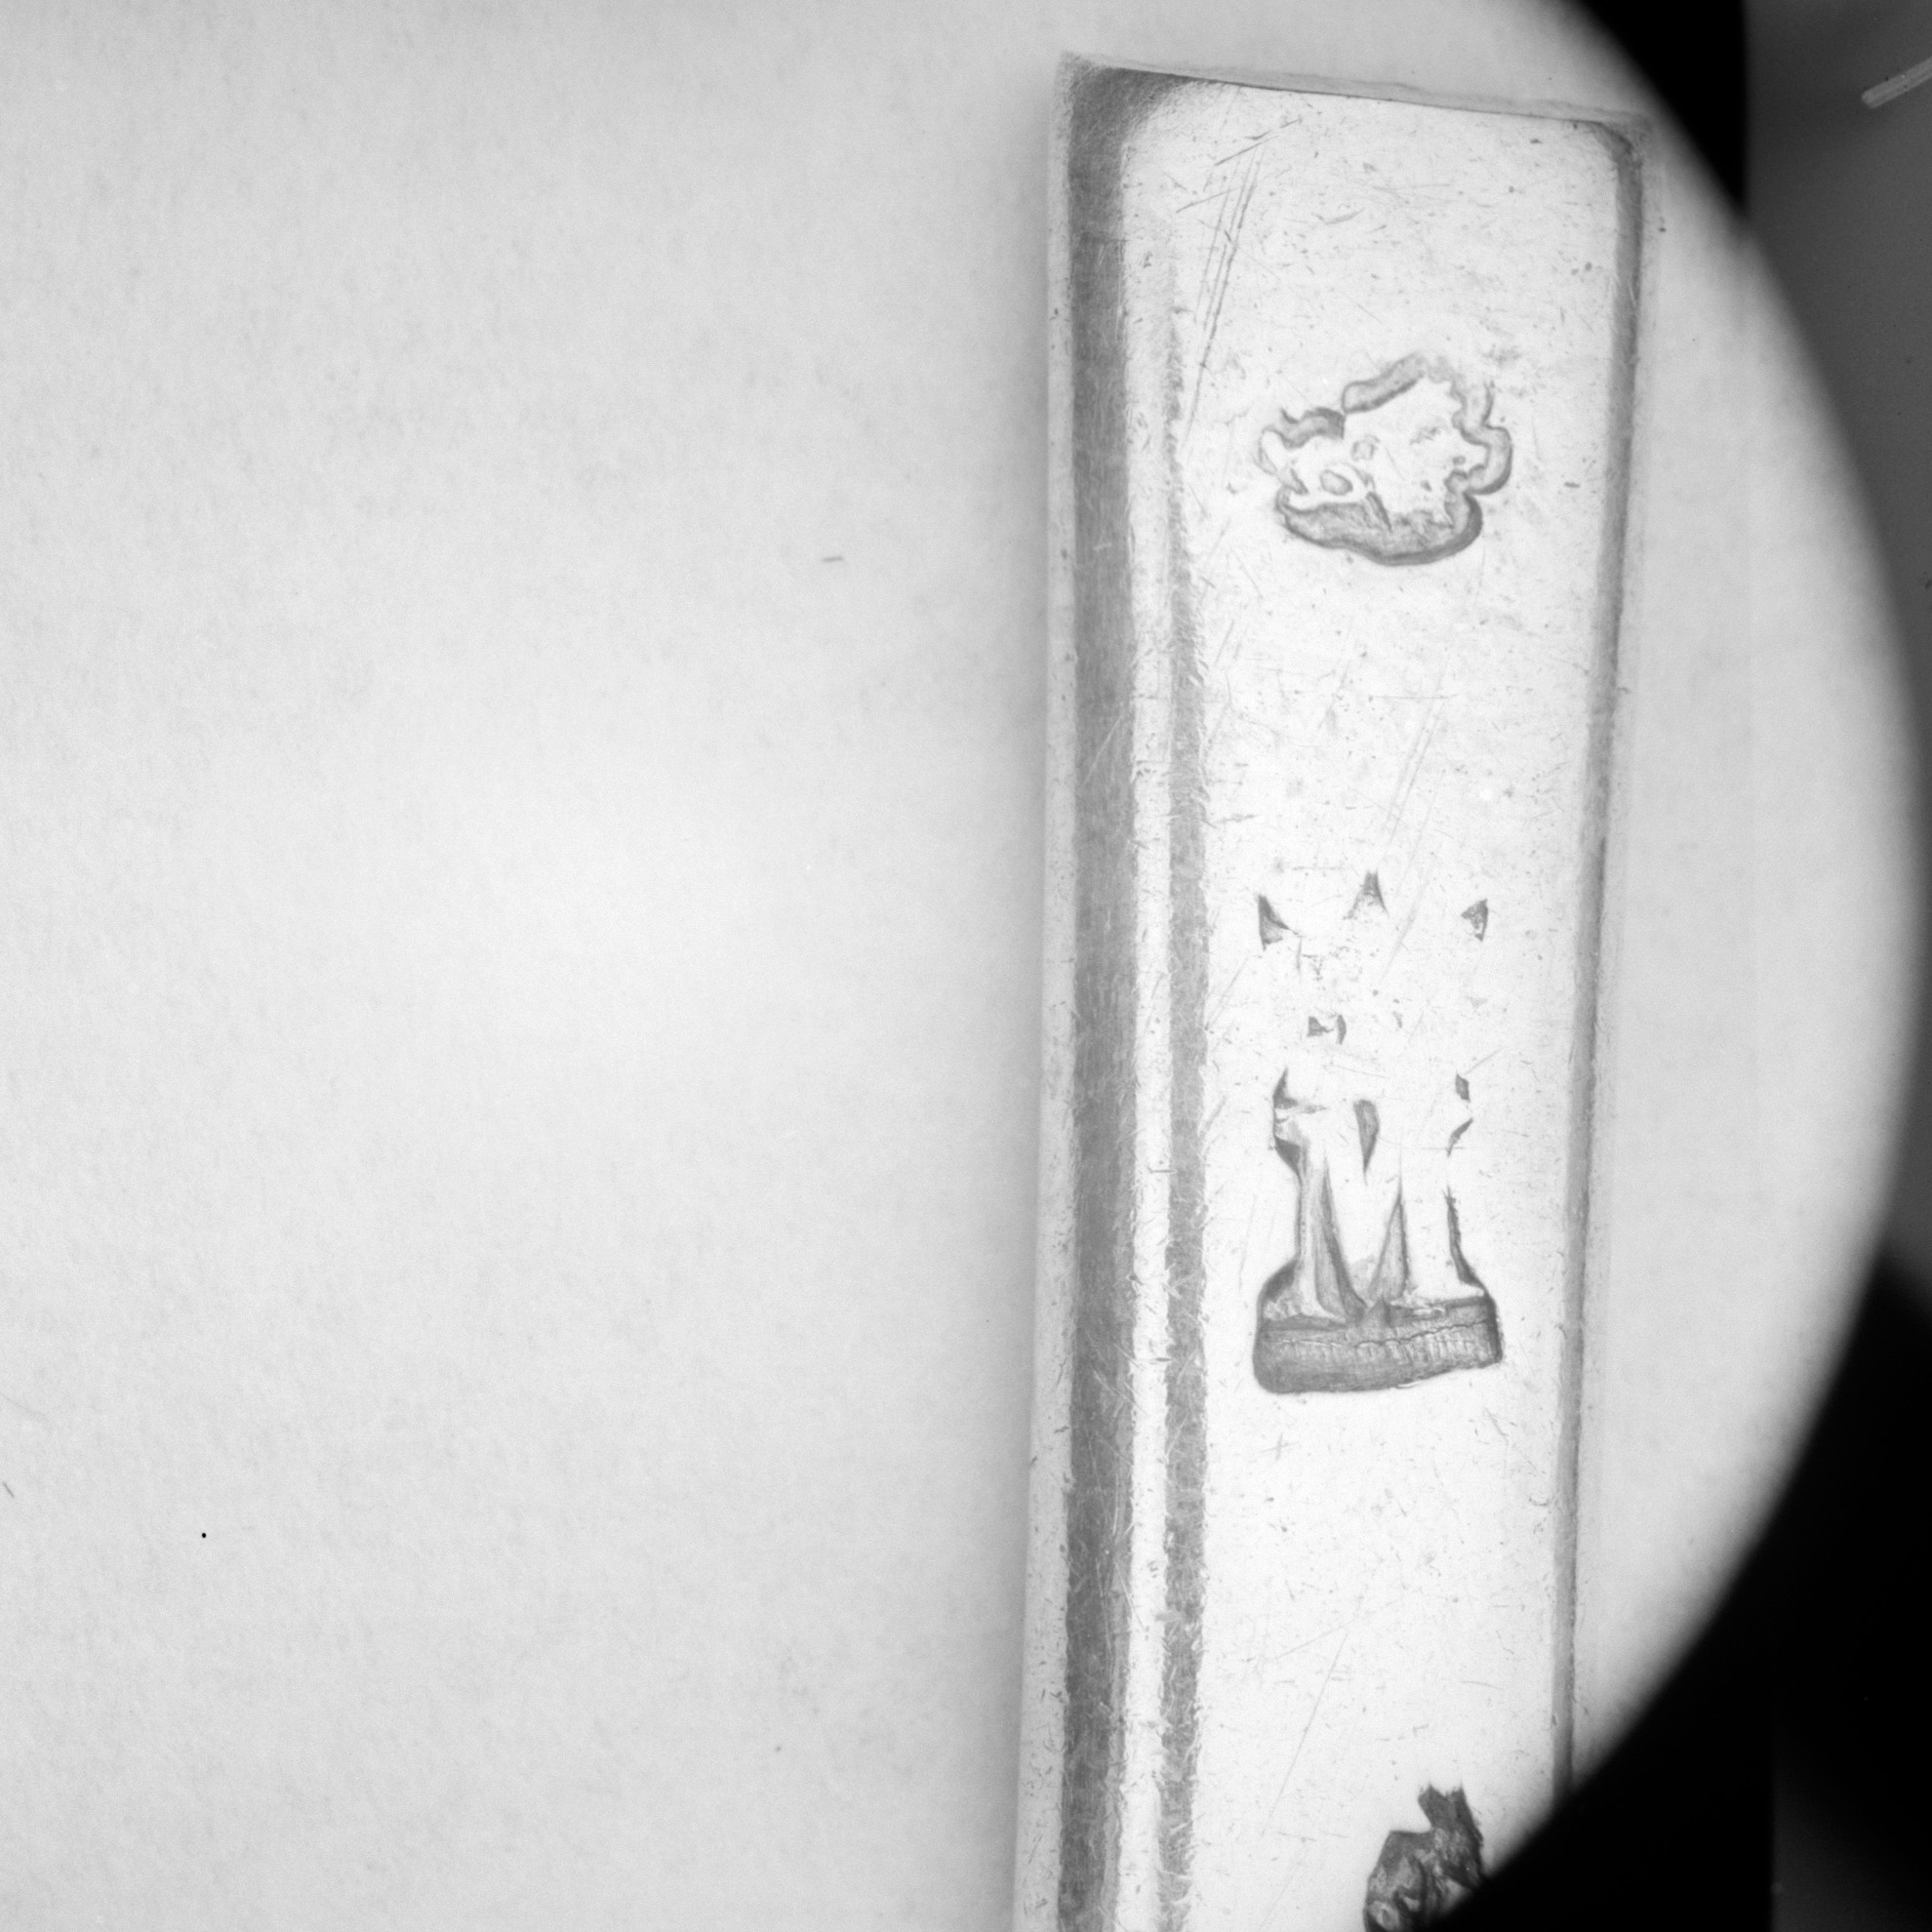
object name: spoon handle section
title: Section of a spoon handle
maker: jean-charles goudière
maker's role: maker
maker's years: 1717-1811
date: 1752-1753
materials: silver